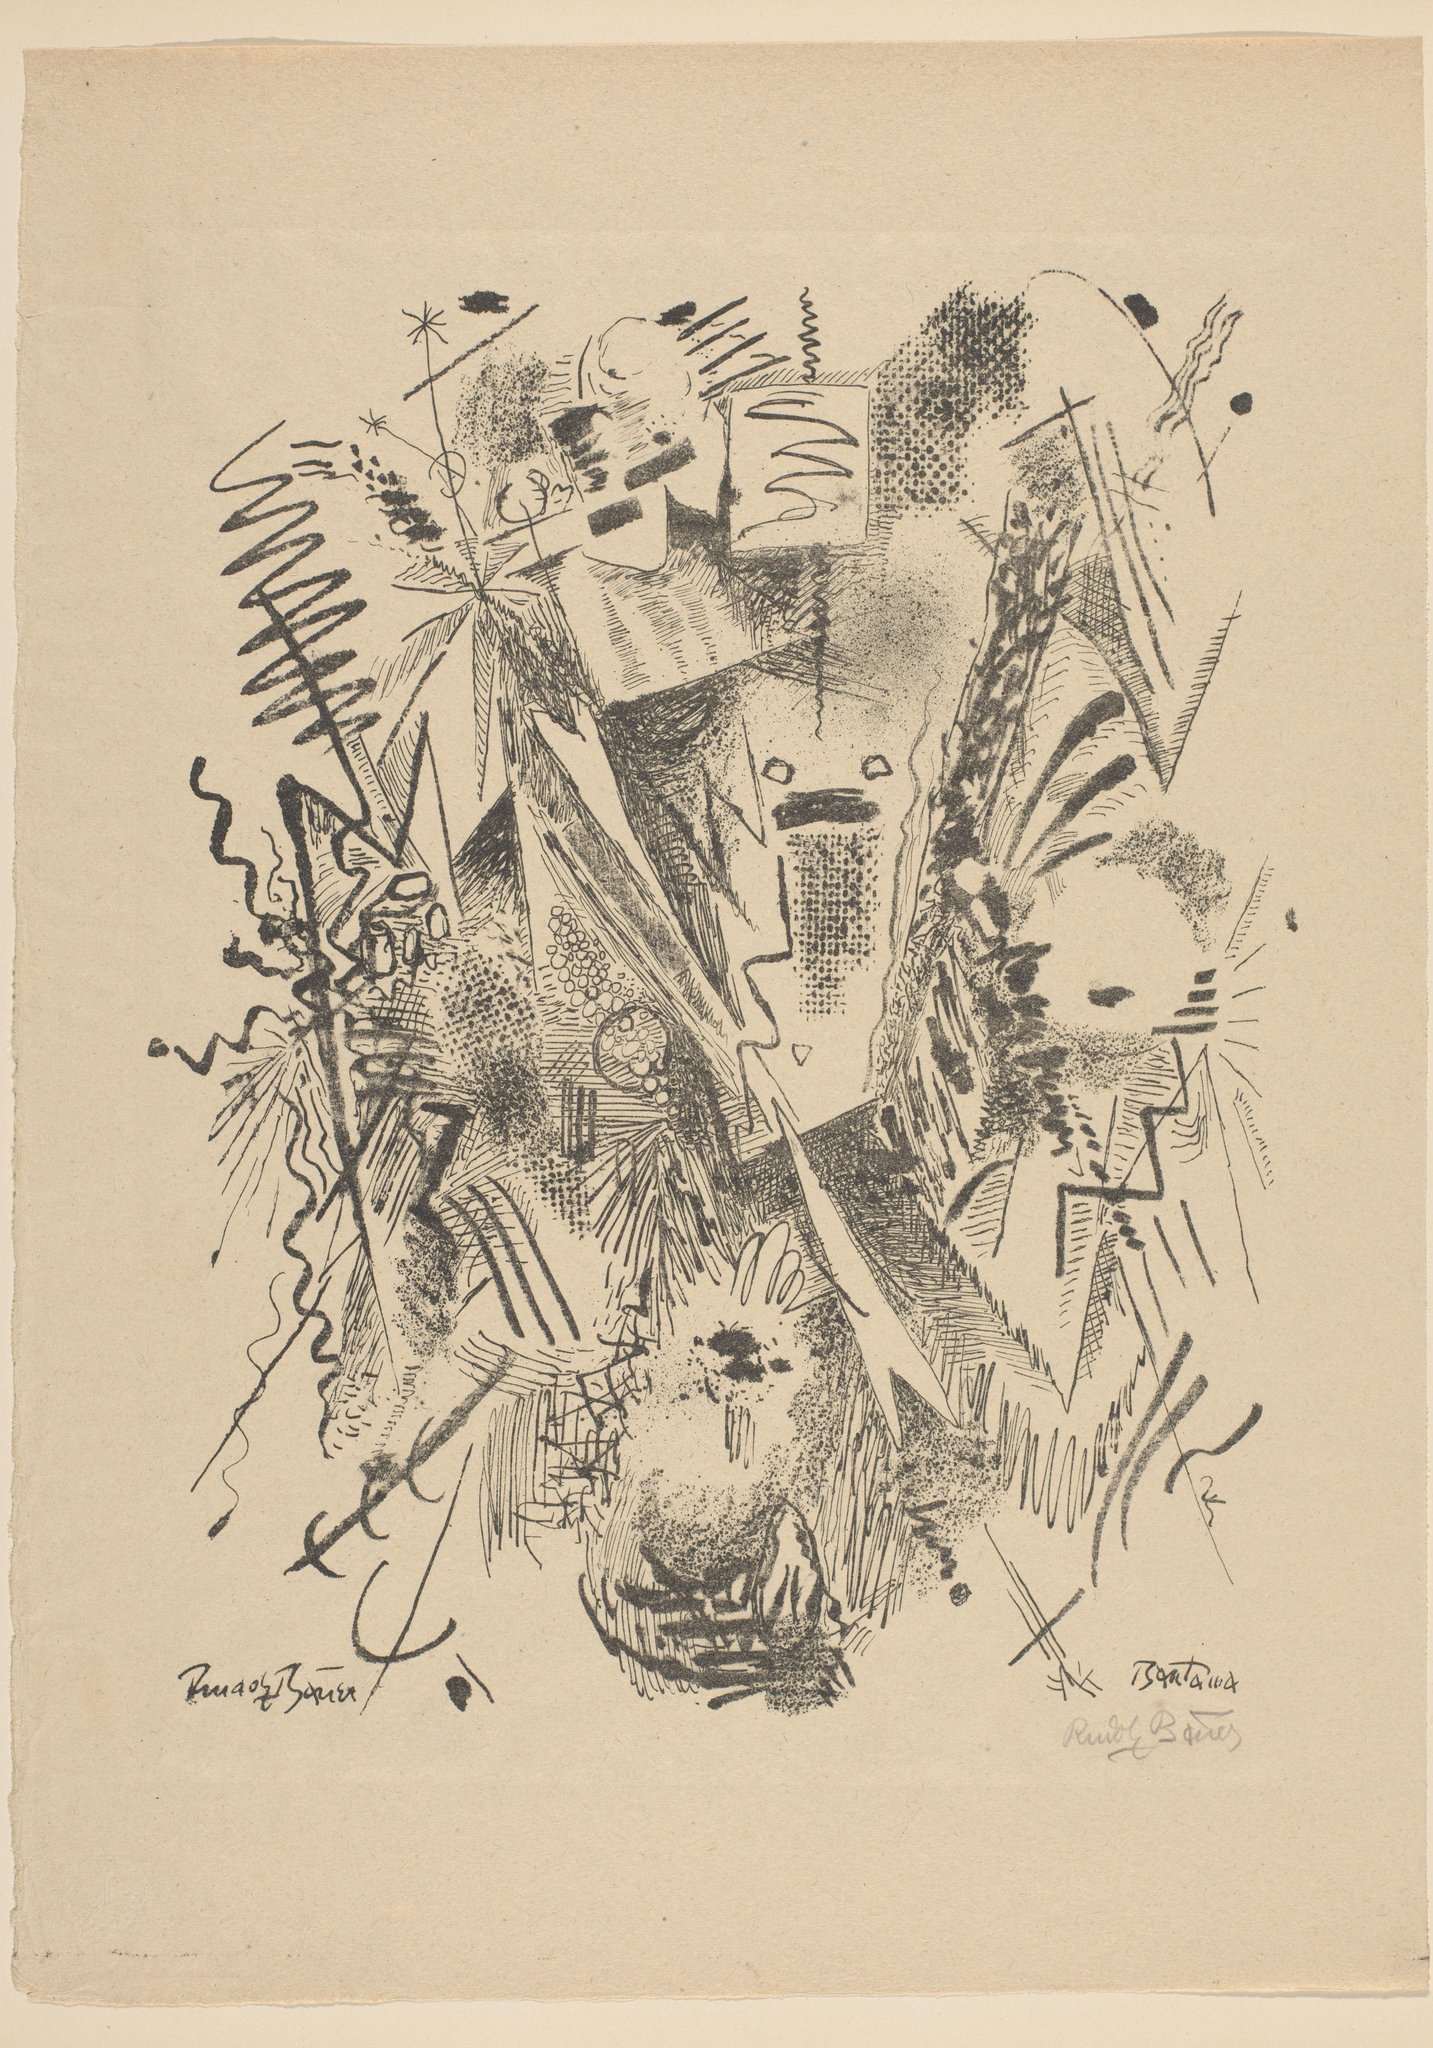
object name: print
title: Bantama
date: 1921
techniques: lithograph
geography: potsdam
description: The third Bauhaus portfolio is devoted to German artists. Der Sturm –the magazine founded by Herwarth Walden, who had an eponymous gallery –was a source for Feininger’s choice of artists. Rudolf Bauer made illustrations for this magazine and taught at Walden’s art academy. The lines and the hatchings in the lithograph Bantama make an explosive impression.